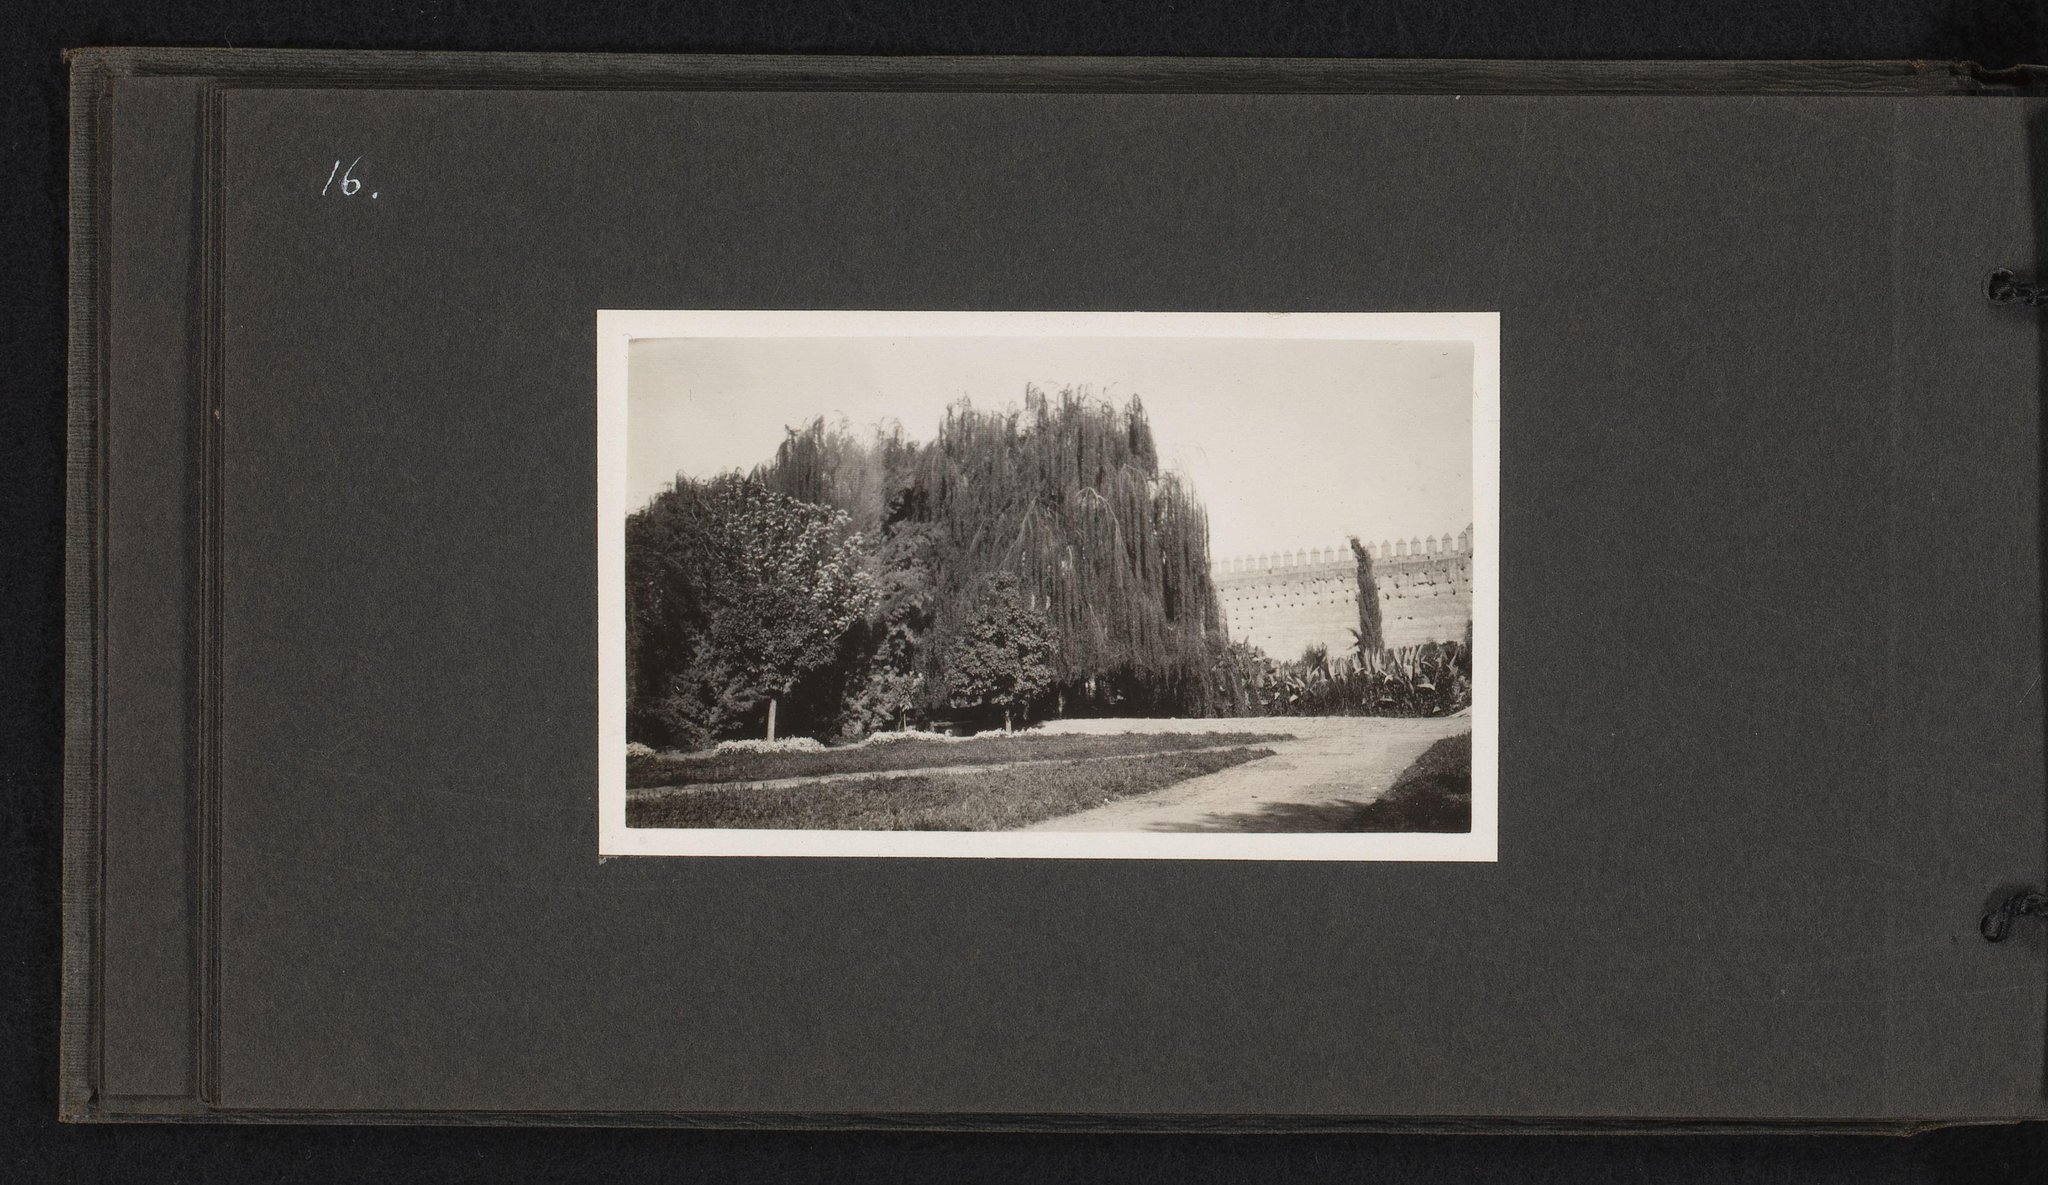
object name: album leaf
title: Treurboomen in een openbaren tuin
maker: a.g.a. van eelde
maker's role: engineer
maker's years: 1862-1950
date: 1927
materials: paper, photographic support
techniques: gelatin silver print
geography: fez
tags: trees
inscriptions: number: ‘16.’